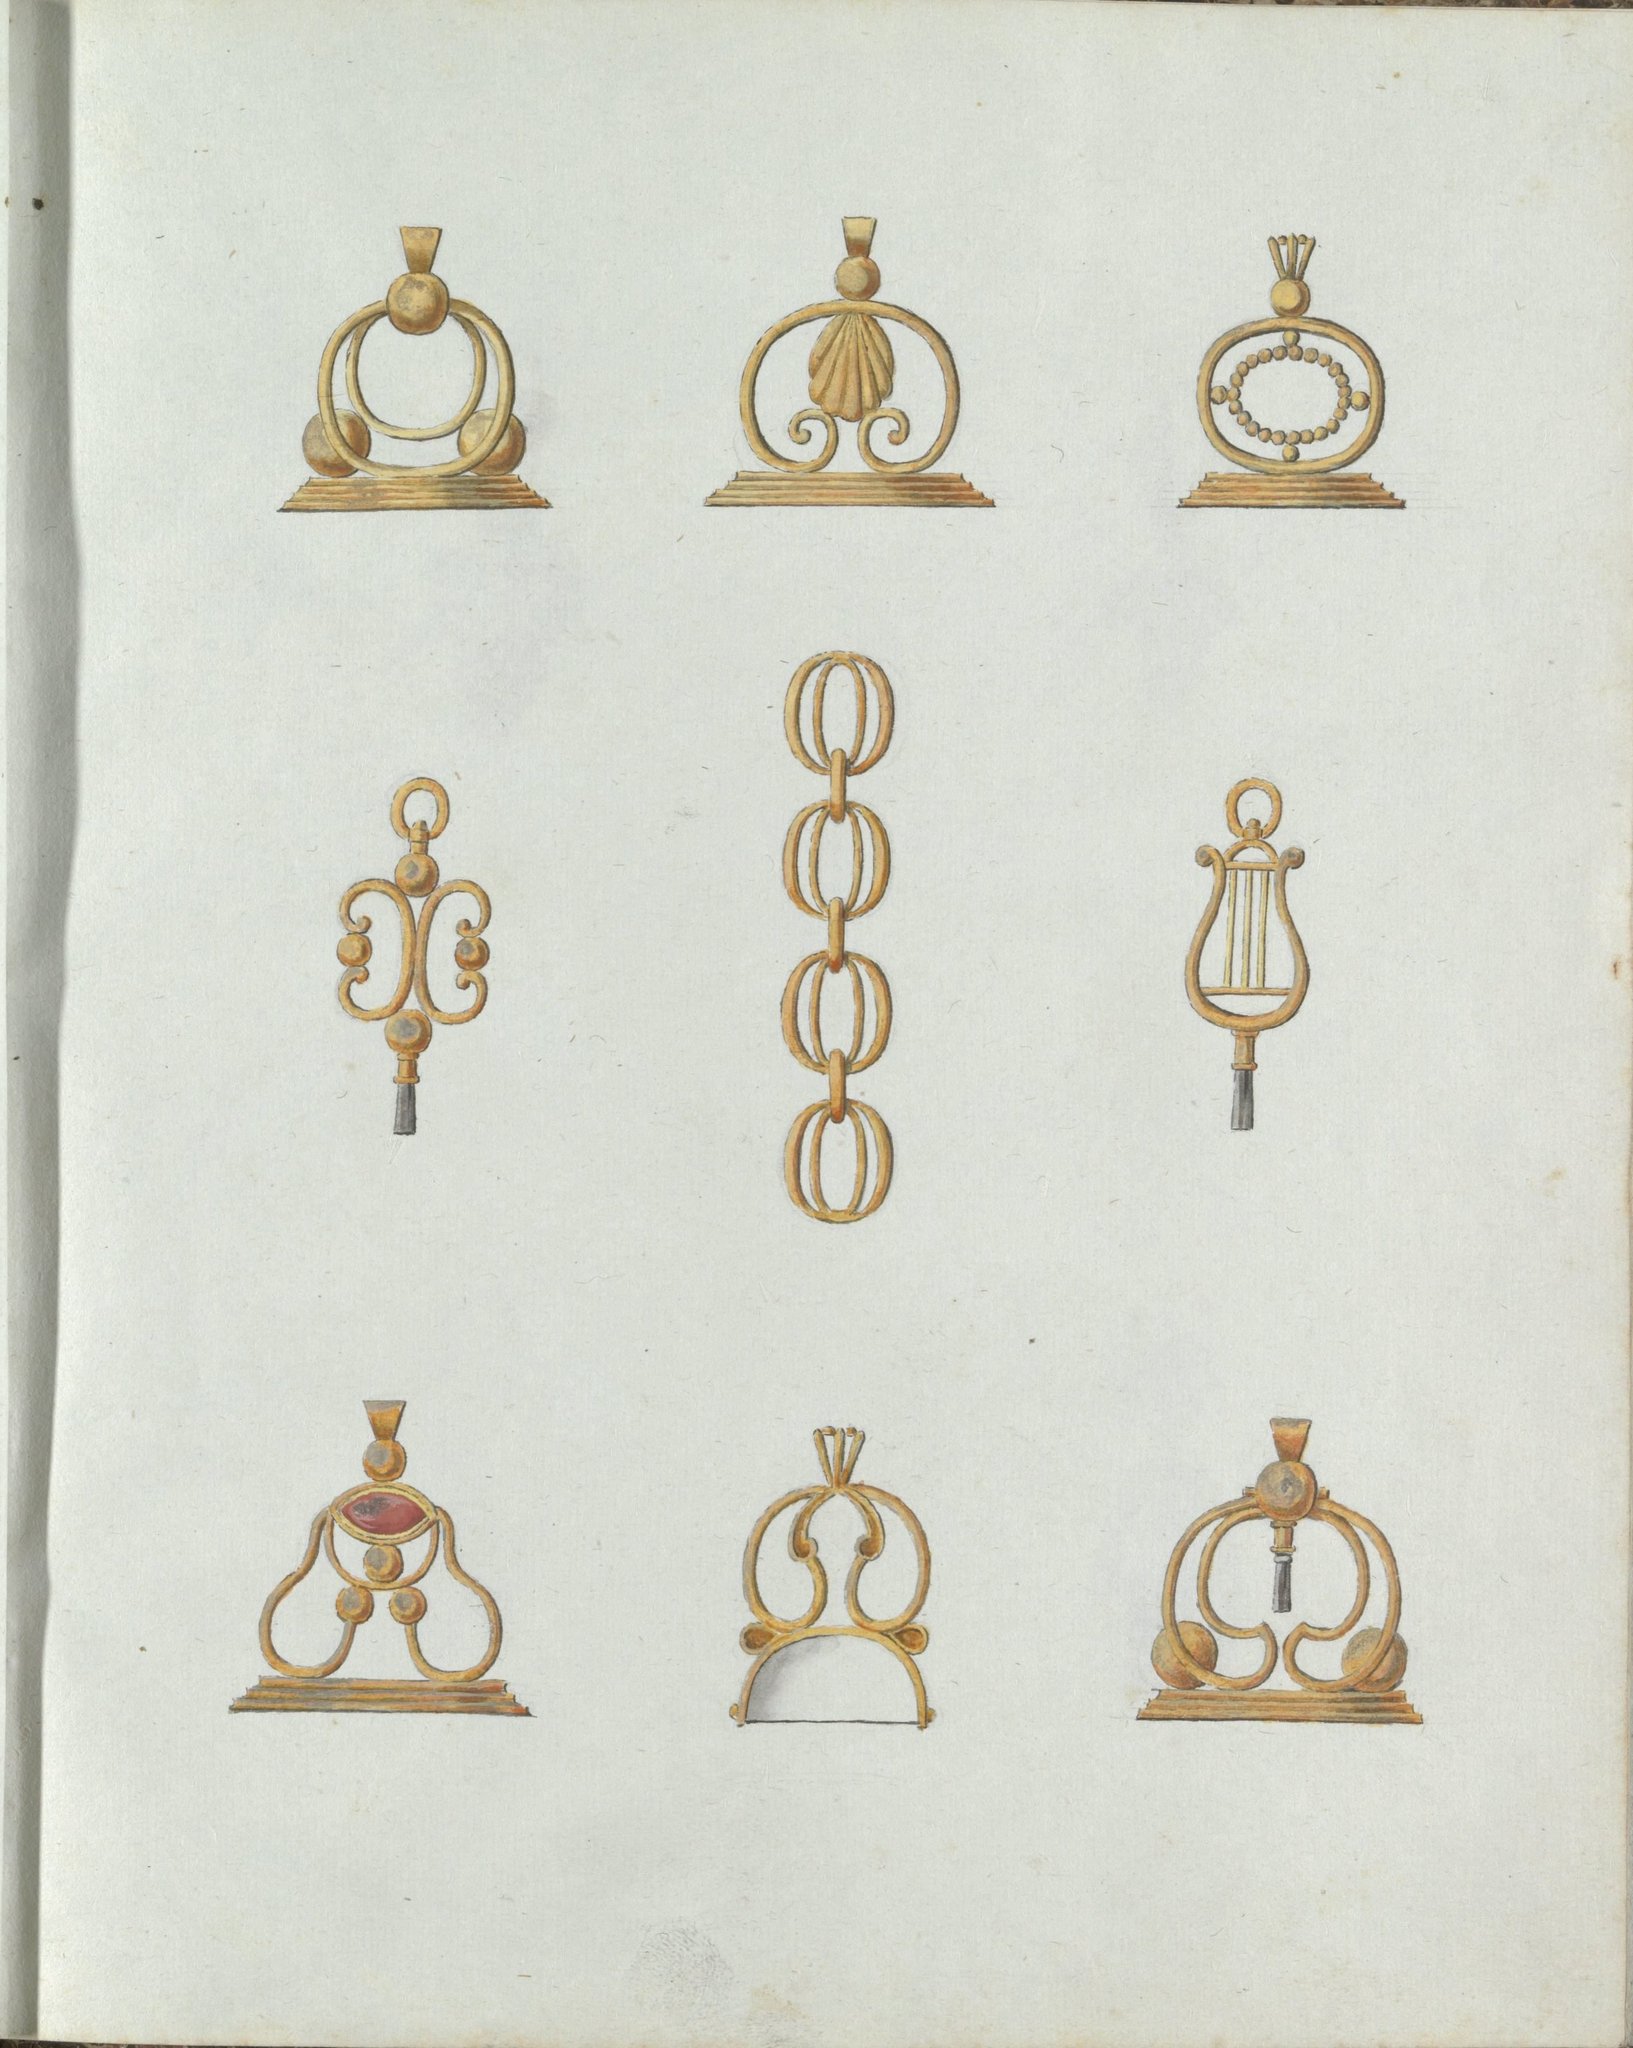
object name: sketchbook leaf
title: Negen ontwerpen van hangers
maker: carl friedrich bärthel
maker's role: draughtsman, jeweler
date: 1800-1810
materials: ink, paper, watercolor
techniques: brush, pen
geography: augsburg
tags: ornaments, jewels